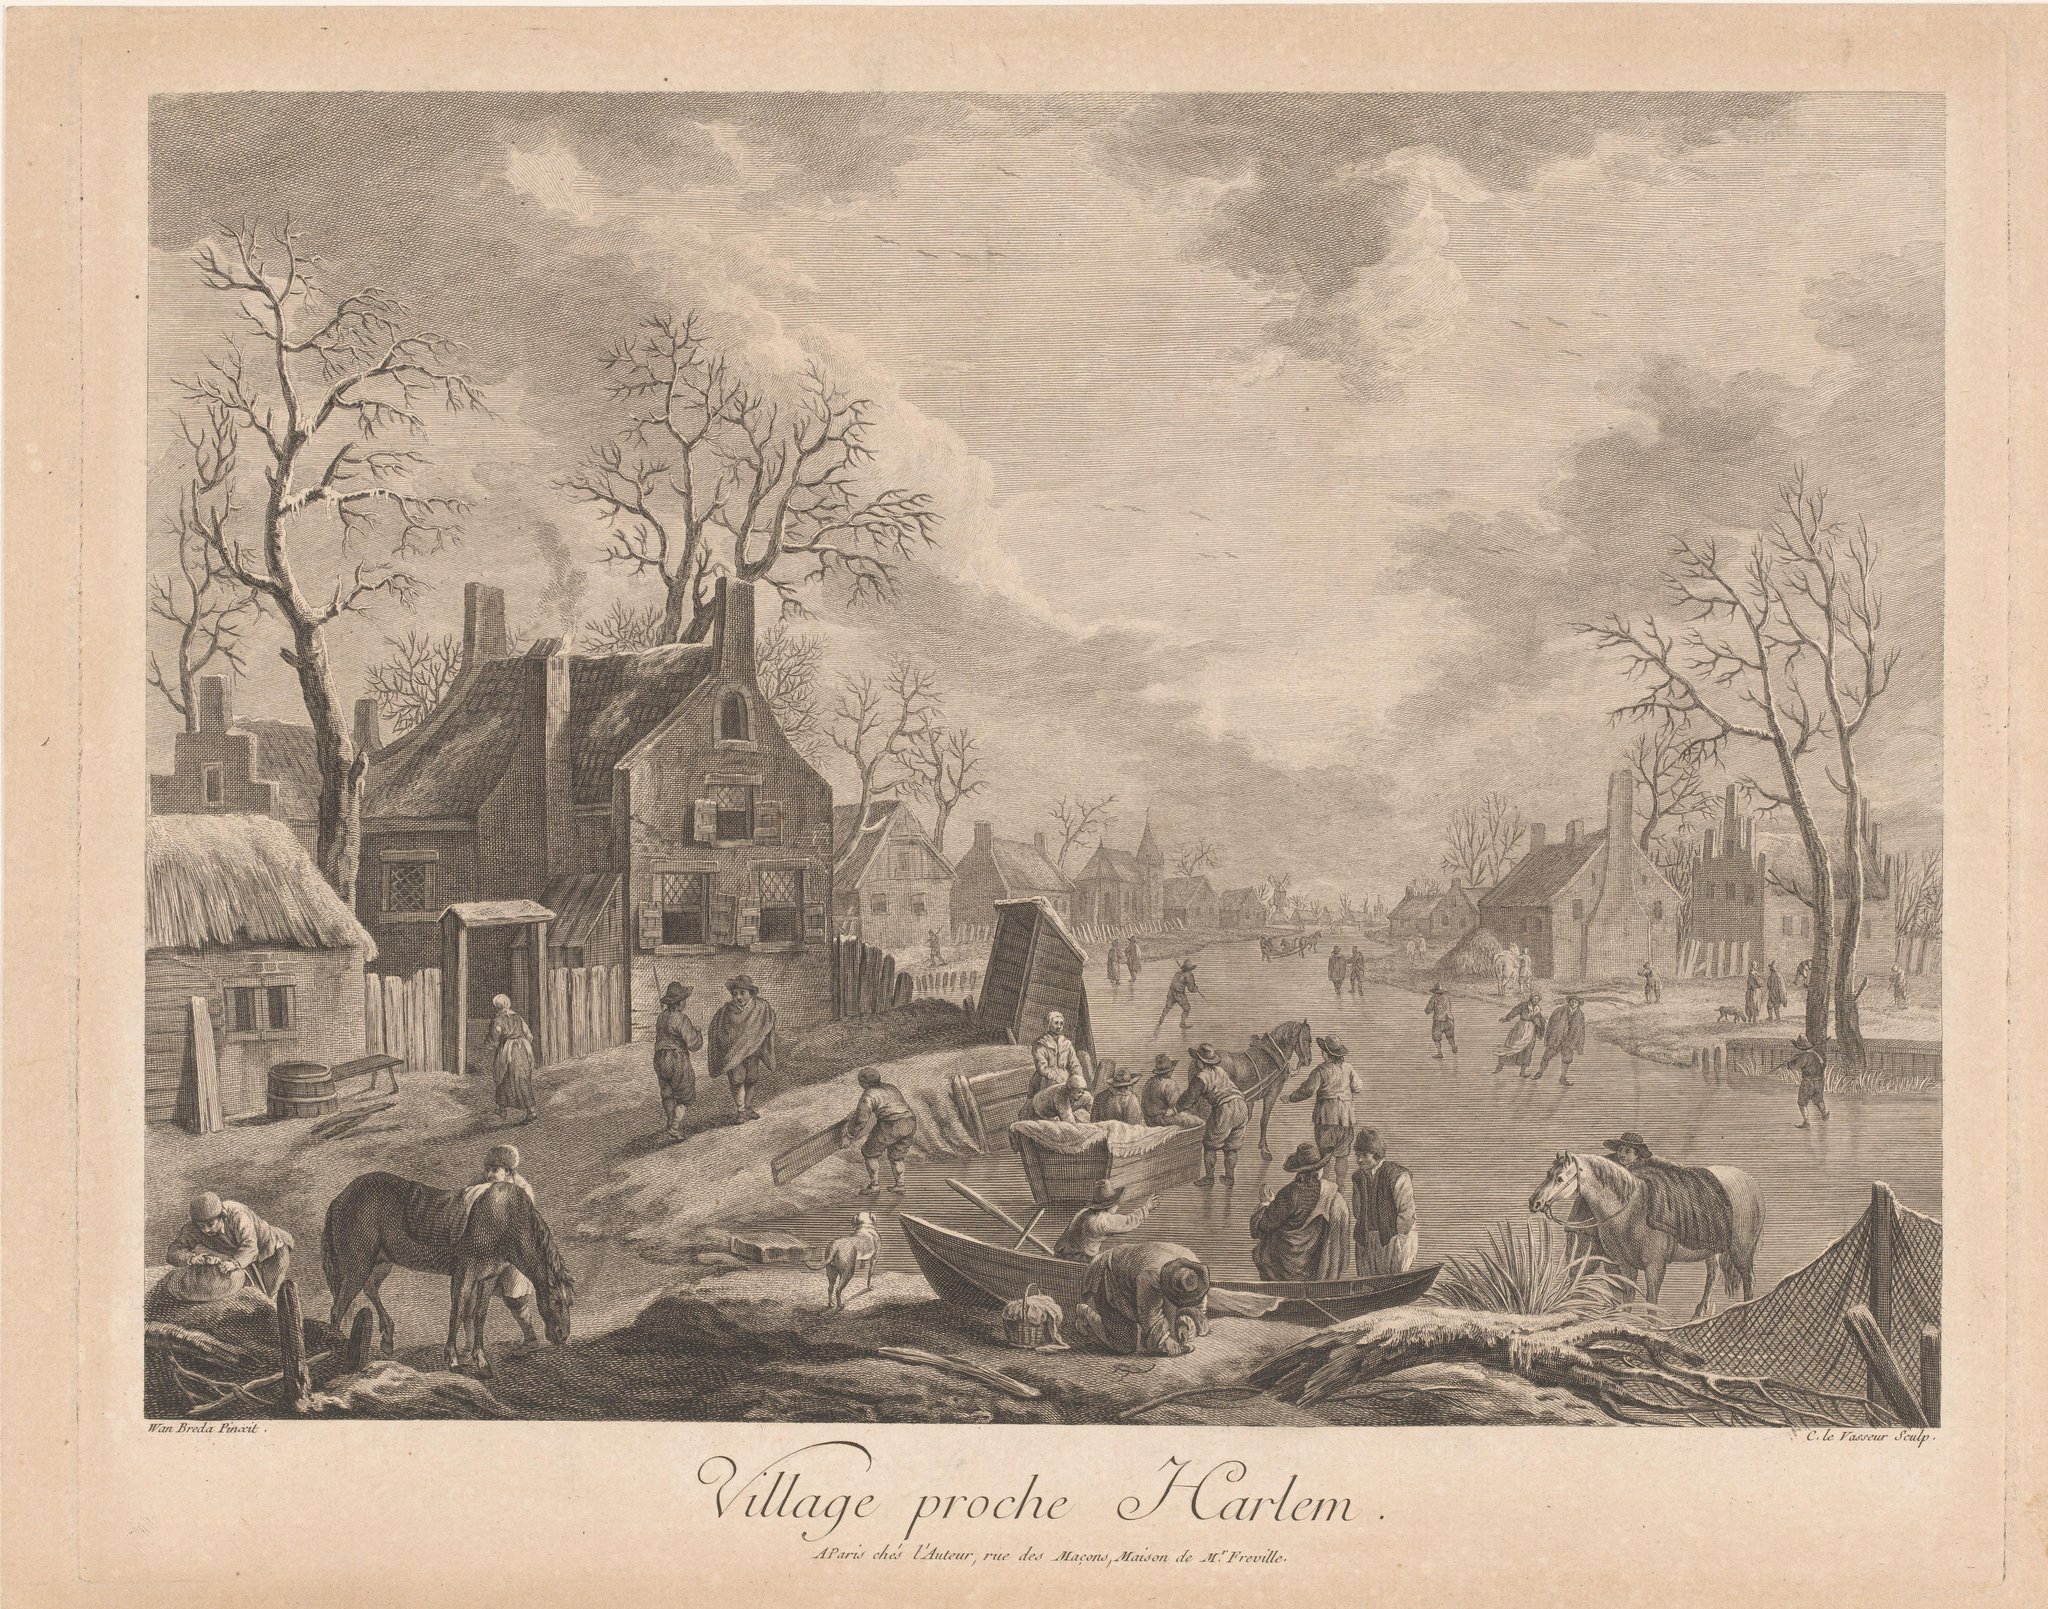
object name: print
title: Village proche Harlem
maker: jean charles le vasseur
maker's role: print maker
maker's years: 1734-1816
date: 1744-1816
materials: paper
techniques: engraving, etching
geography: paris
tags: village, sleigh, sledge (non-sport), winter landscape; landscape symbolizing winter (the four seasons of the year), skates (winter sports)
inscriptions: collector's mark: Lugt 2228